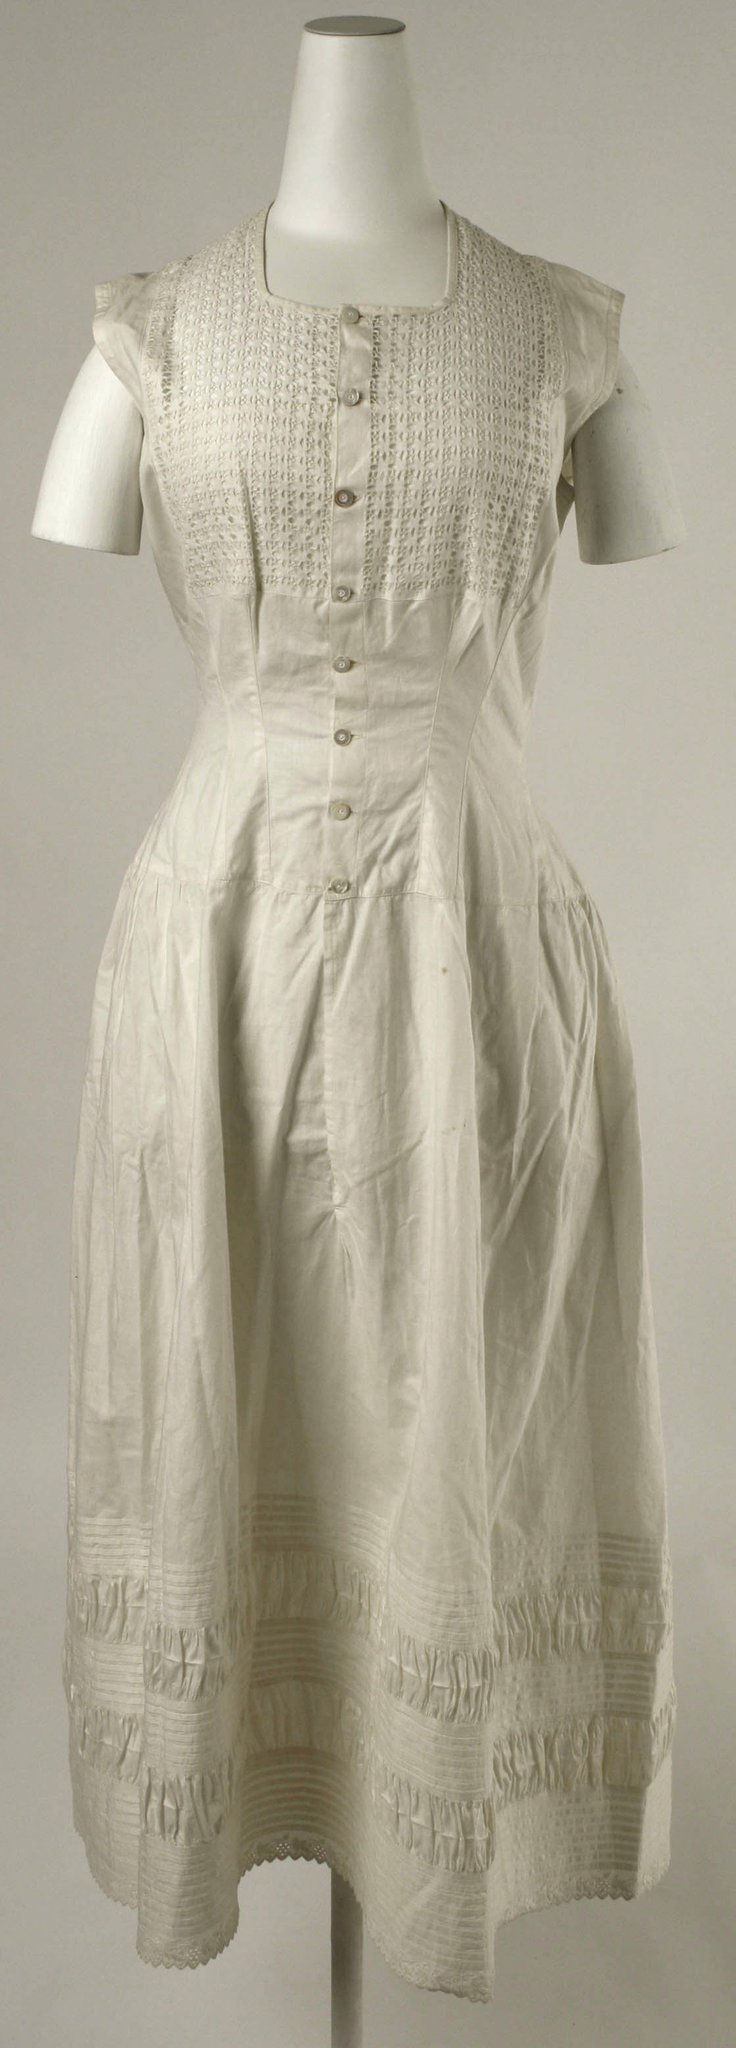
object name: chemise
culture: american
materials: cotton